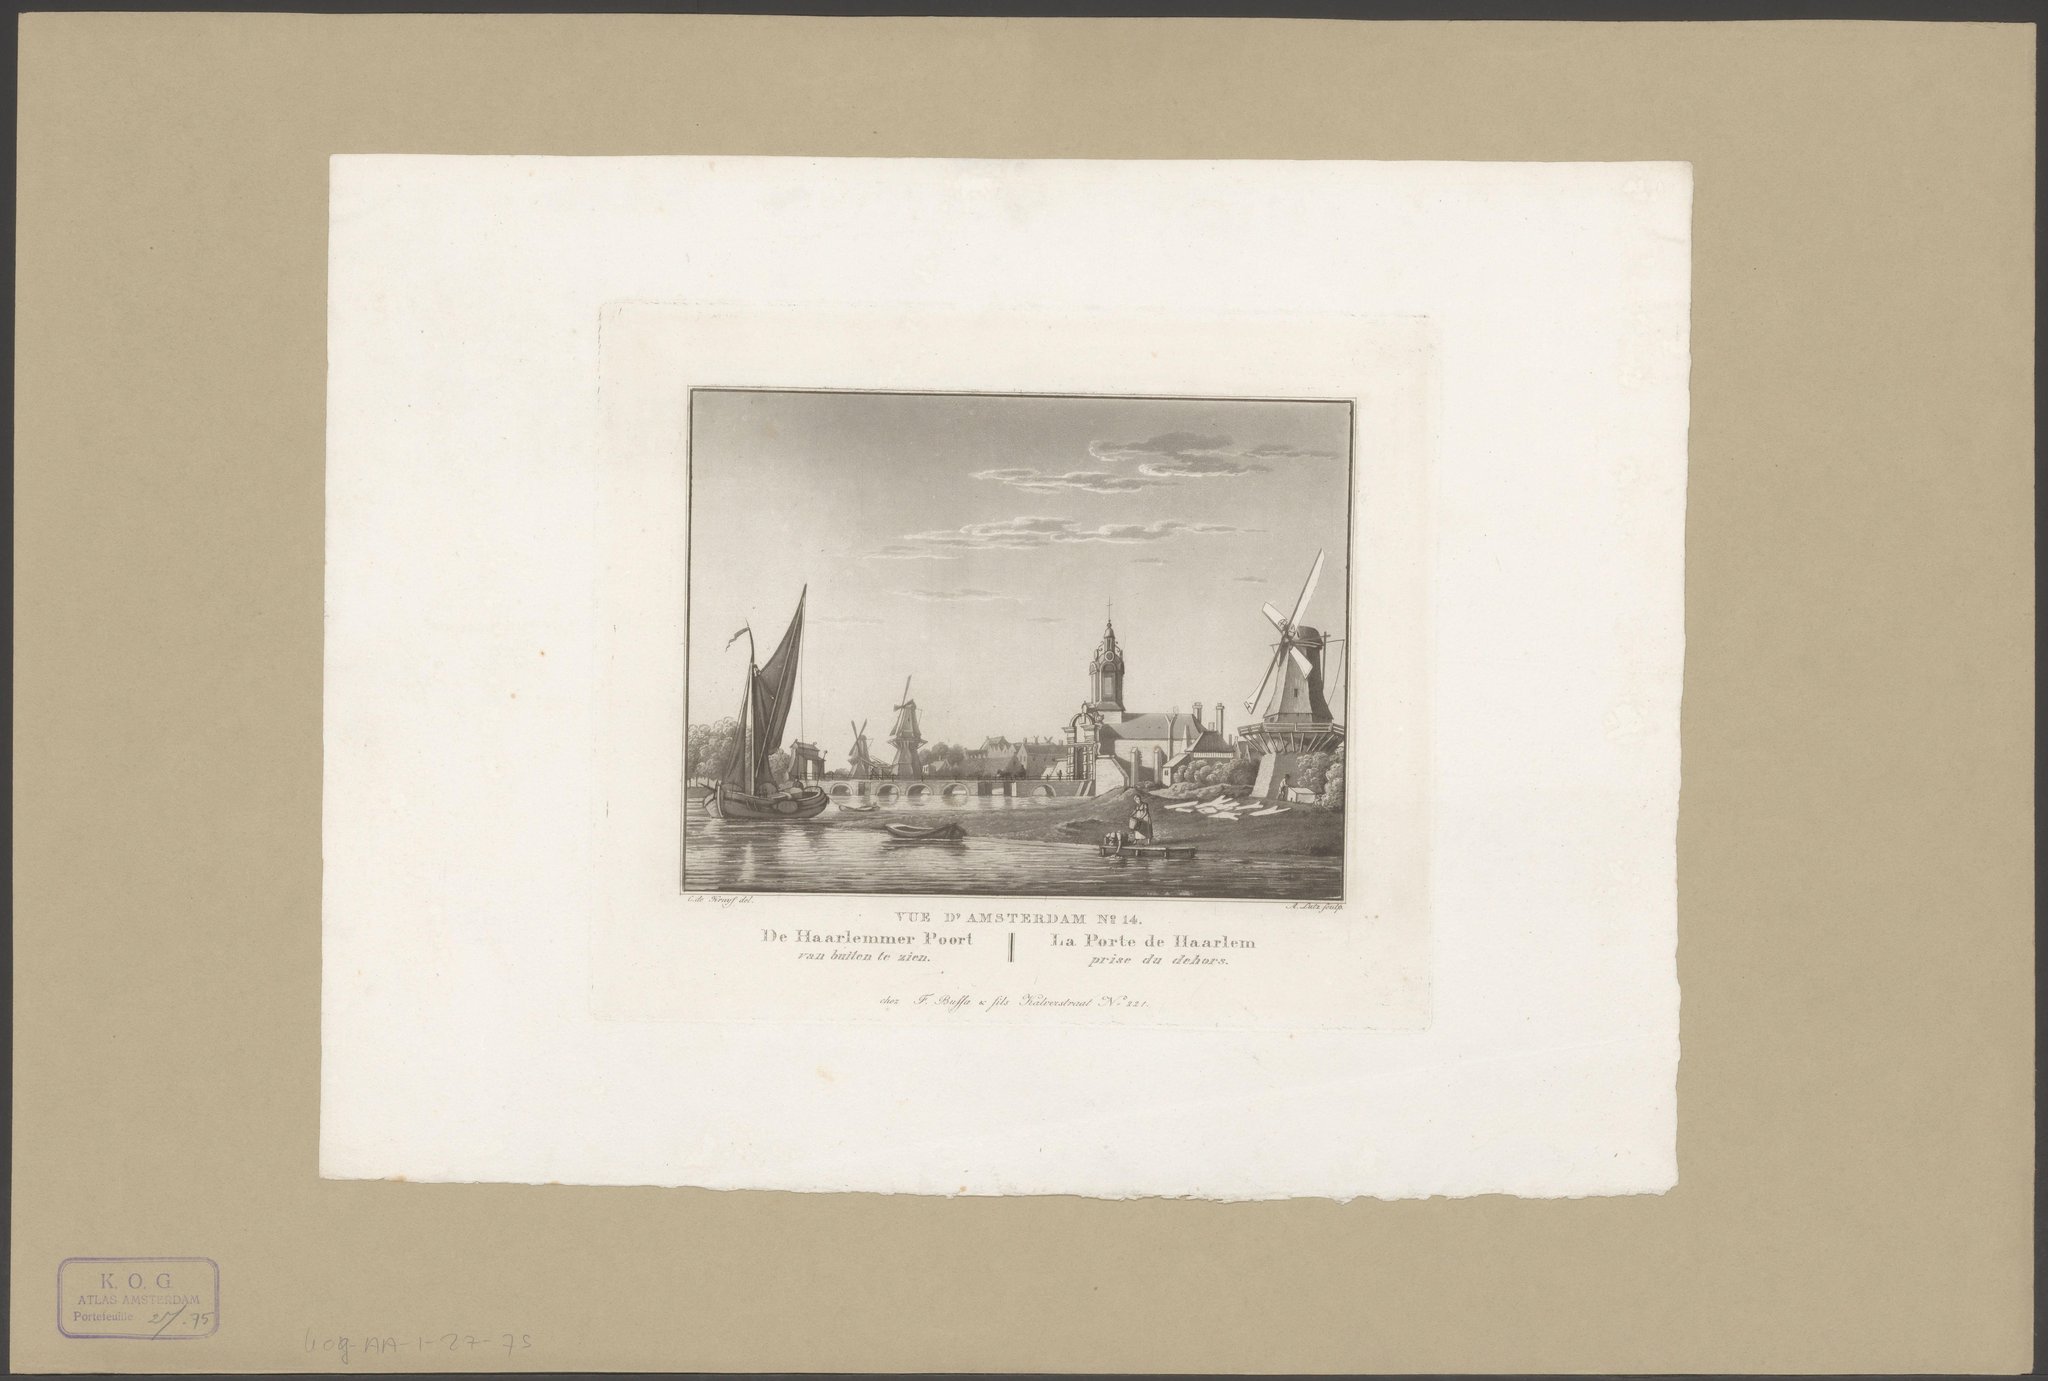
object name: print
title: Vues choisies d'Amsterdam et ses Environs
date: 1827-1900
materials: paper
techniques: aquatint, engraving, etching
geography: amsterdam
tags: rowing-boat, canoe, etc., bridge in city across river, canal, etc.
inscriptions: collector's mark: Lugt 1641b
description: Prent mogelijk uit: Kruyff, Cornelis de. Vues choisies d'Amsterdam et ses environs. Amsterdam: Frans Buffa en Zonen, 1825.